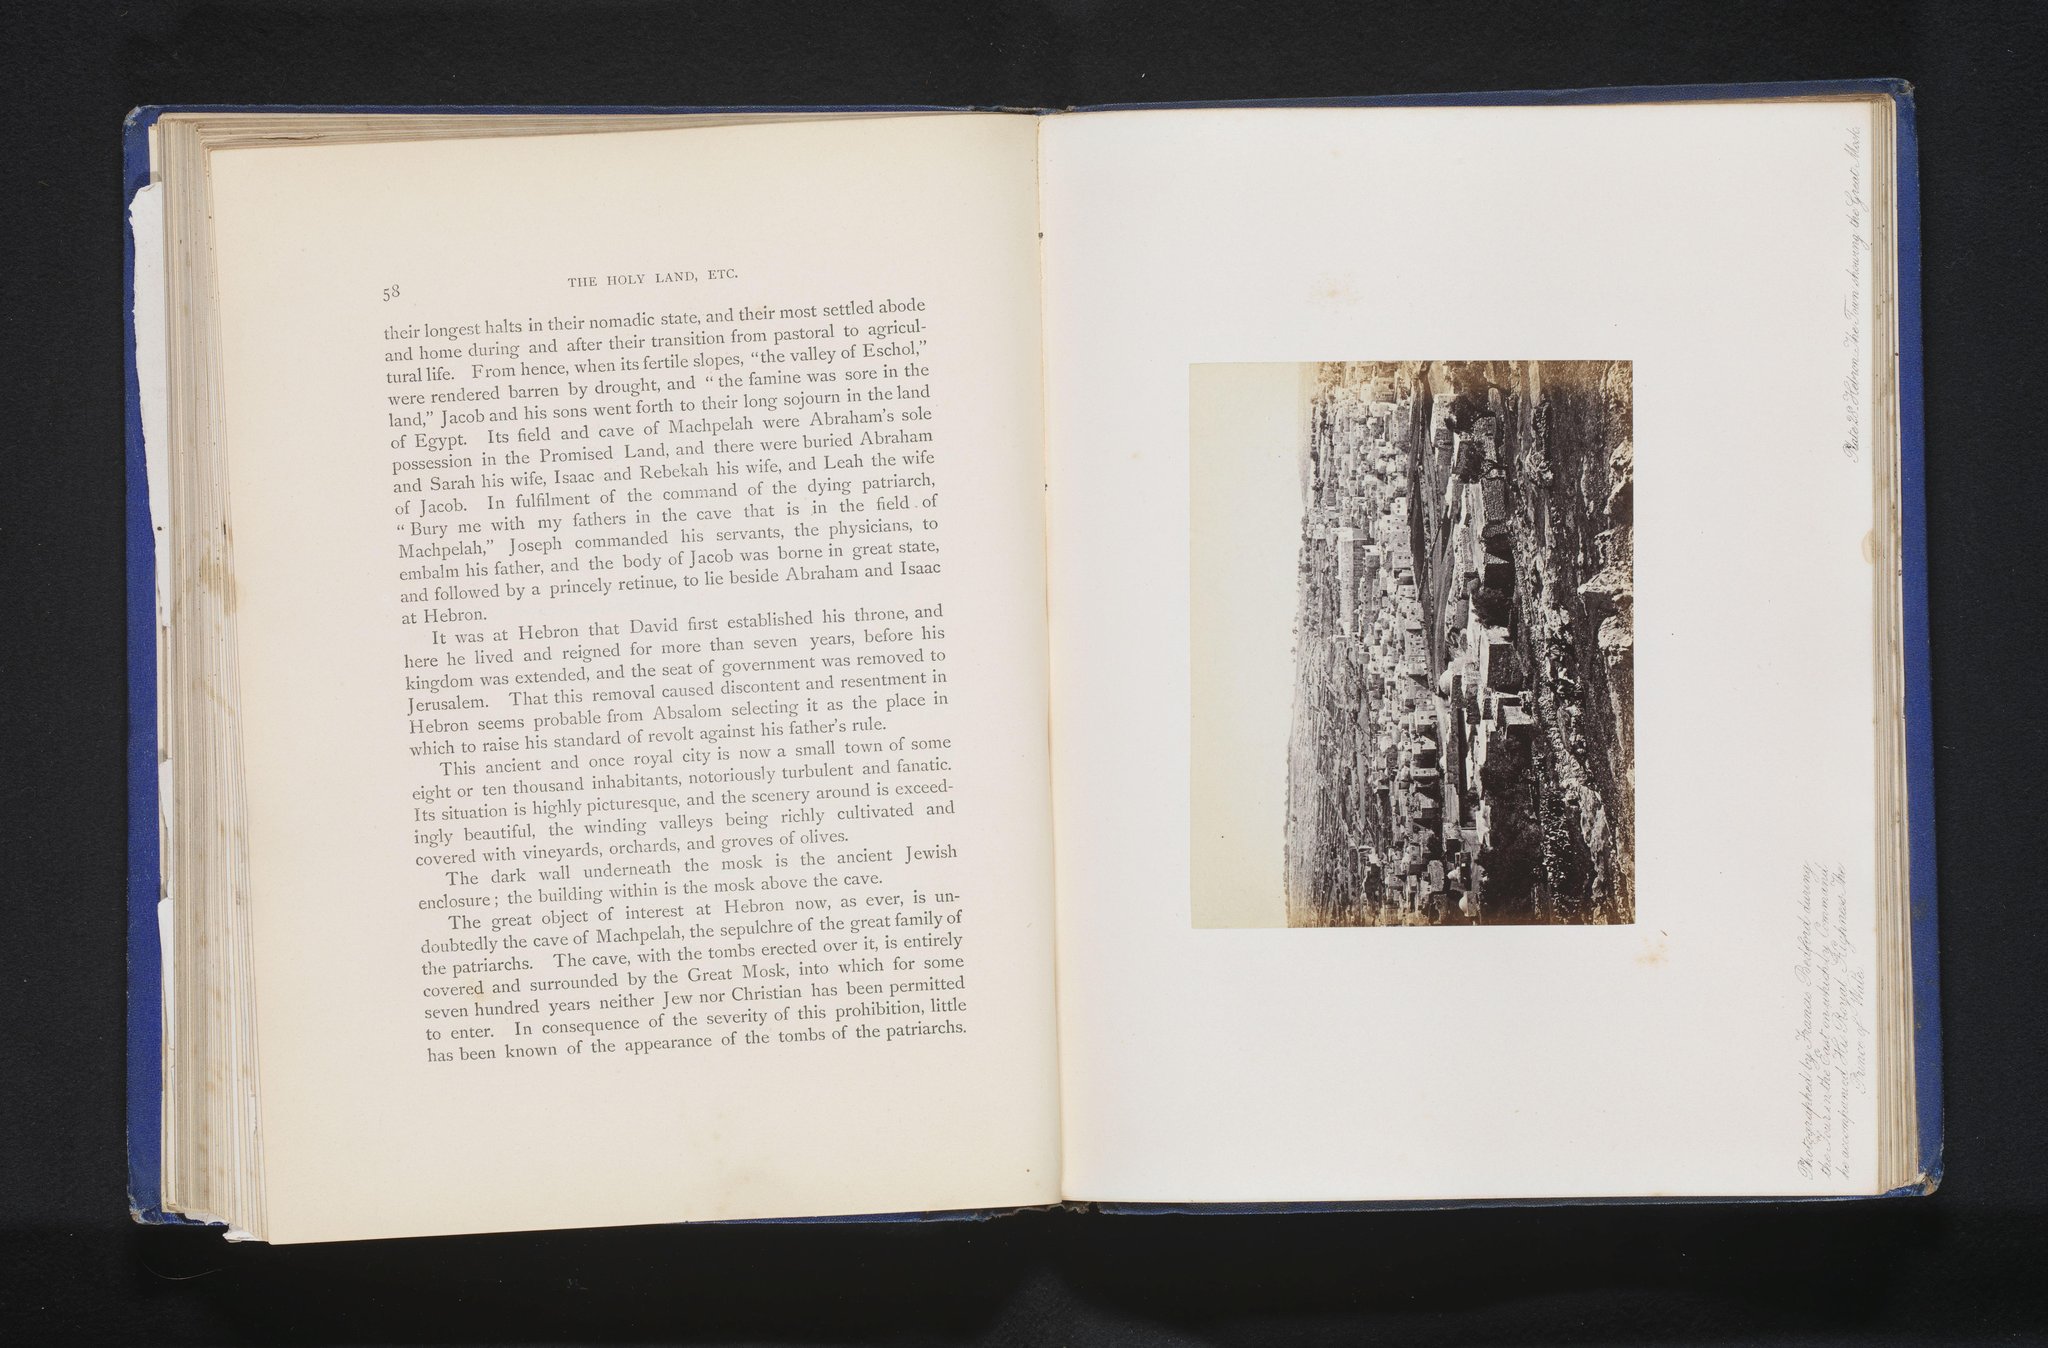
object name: page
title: Hebron-The town showing the Great Mosk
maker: francis bedford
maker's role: print maker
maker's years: 1815-1894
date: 1861-1866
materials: photographic support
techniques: albumen print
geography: palestine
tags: city-view in general; 'veduta'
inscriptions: inscription: ‘Photographed by Francis Bedford during the Tour in the East on which by Command he accompanied His Royal Highness The Prince of Wales’, number: ‘Plate 28.’